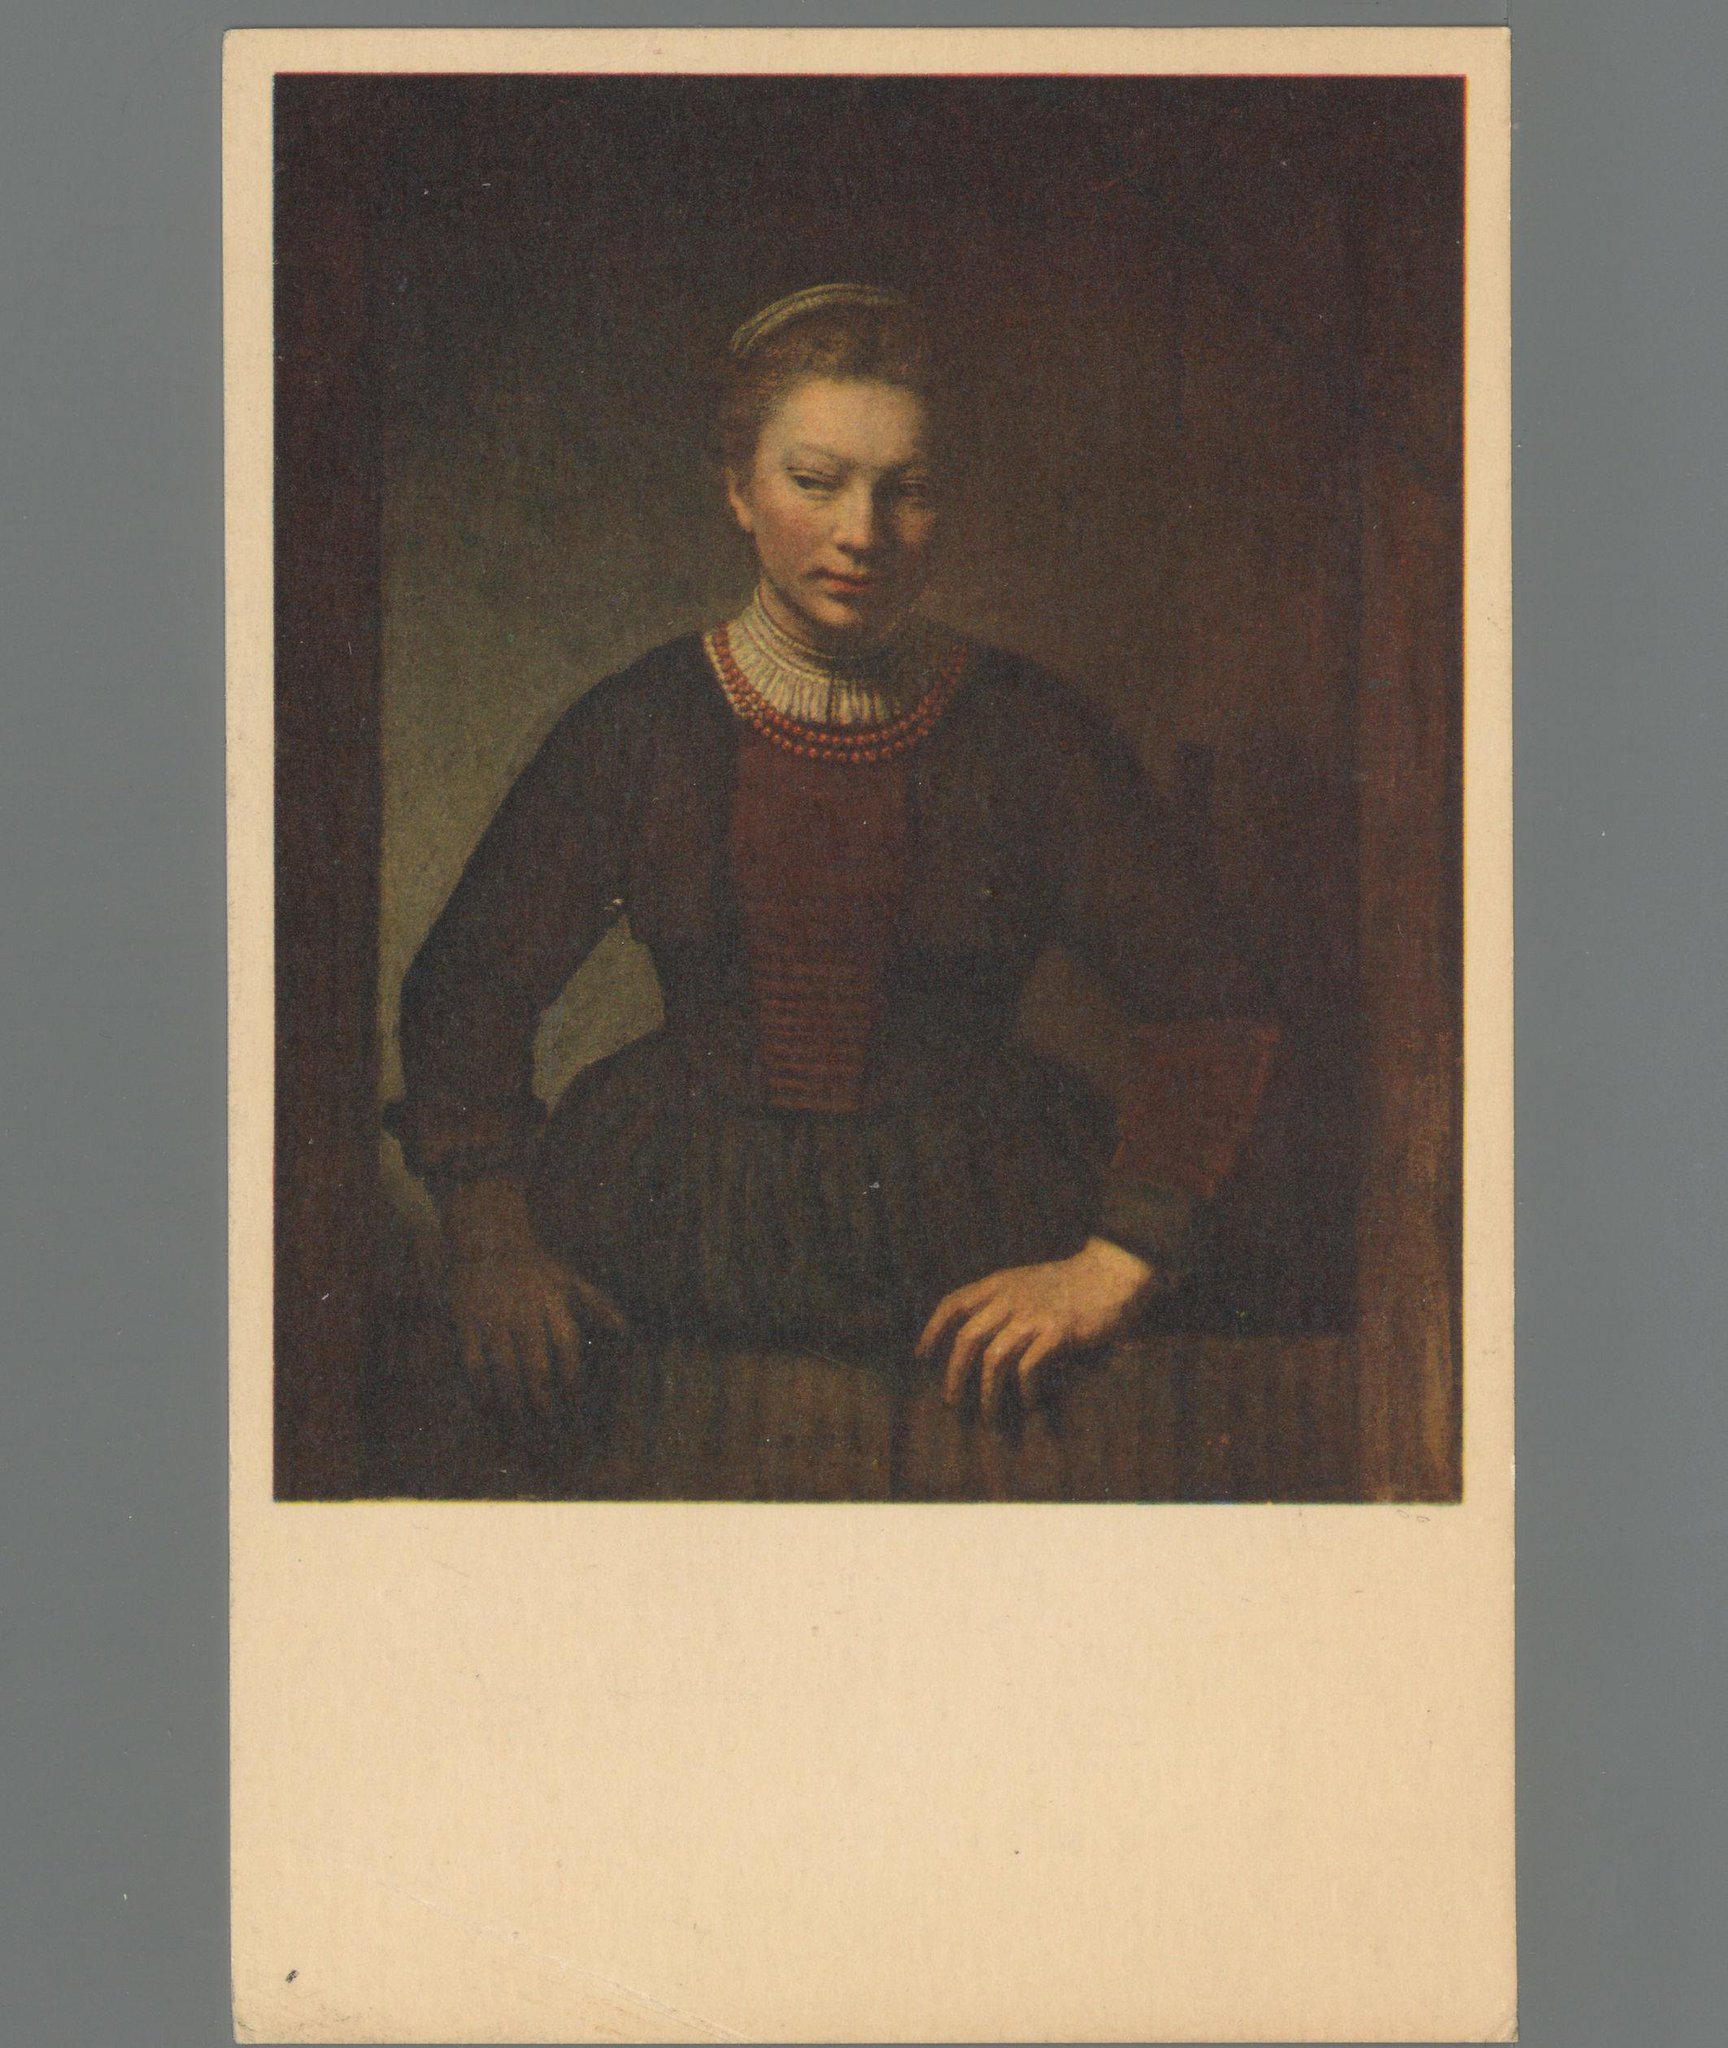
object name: photomechanical print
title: Young girl at an opened half door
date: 1920-1950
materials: cardboard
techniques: photograph, lithograph, typewriting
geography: chicago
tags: divided door, upper part opened, adult man (+ standing)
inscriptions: postage stamp